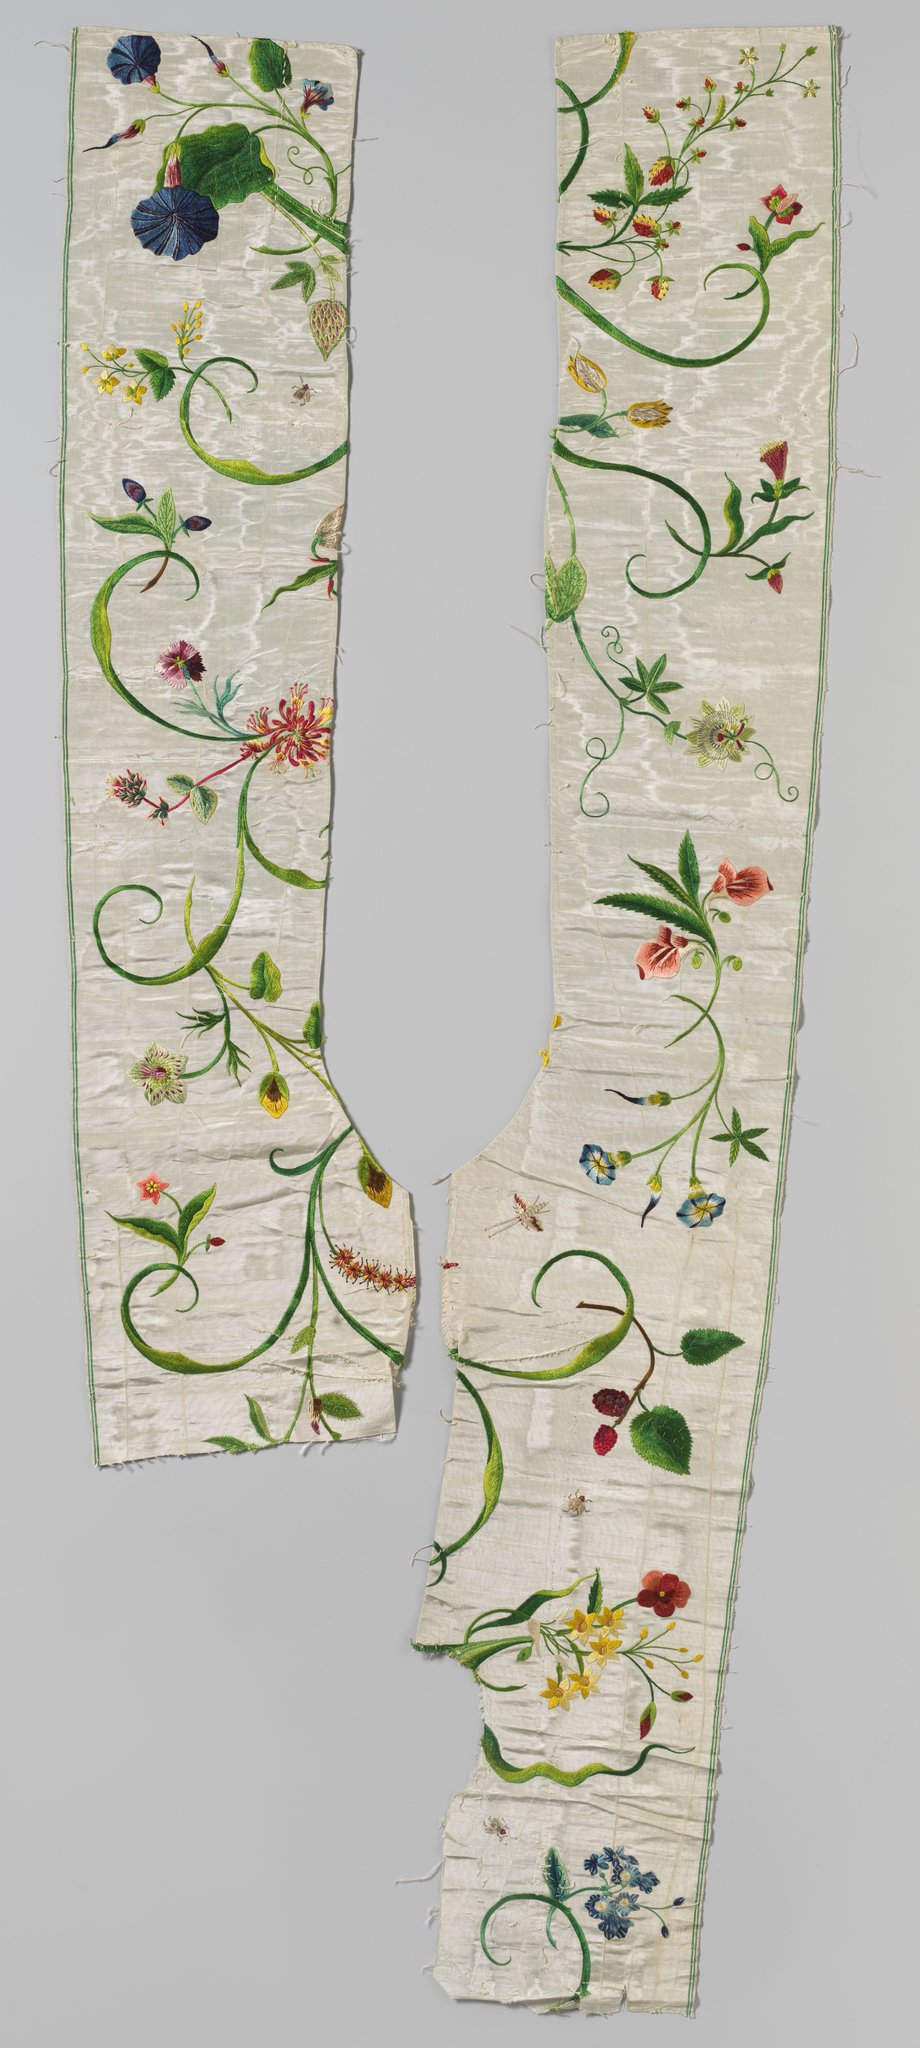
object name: fragment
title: Fragment van een japon van witte moirézijde, rijk geborduurd met bloemranken in veelkleurige zijde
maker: Anonymous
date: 1775-1800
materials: silk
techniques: embroidered, moire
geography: europe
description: Fragment van een japon van witte moirézijde, rijk geborduurd met bloemranken in veelkleurige zijde.